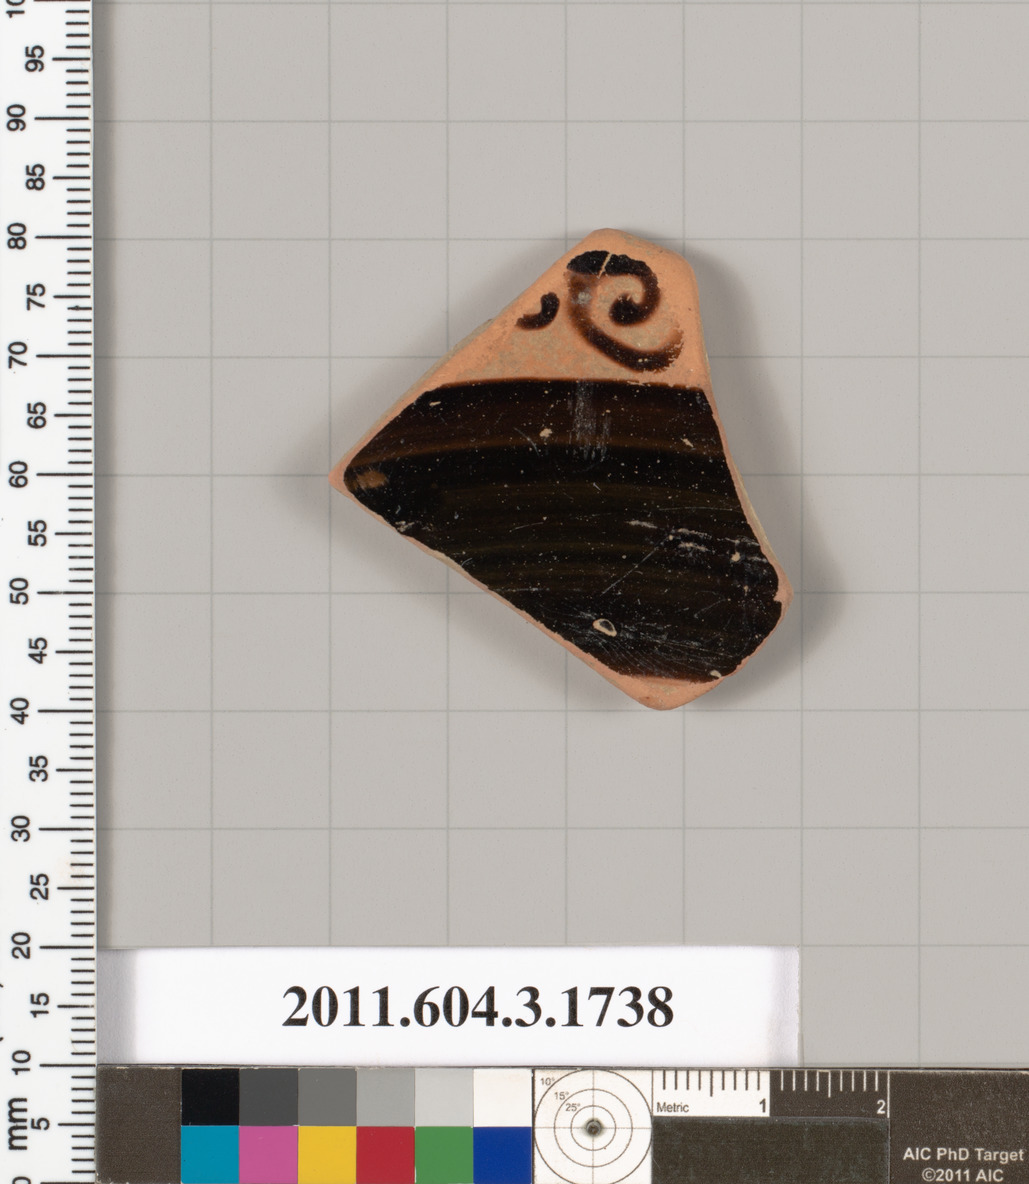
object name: kylix fragment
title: Terracotta fragment of a kylix: Lip cup (drinking cup)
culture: greek, attic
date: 550-526 BCE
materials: terracotta